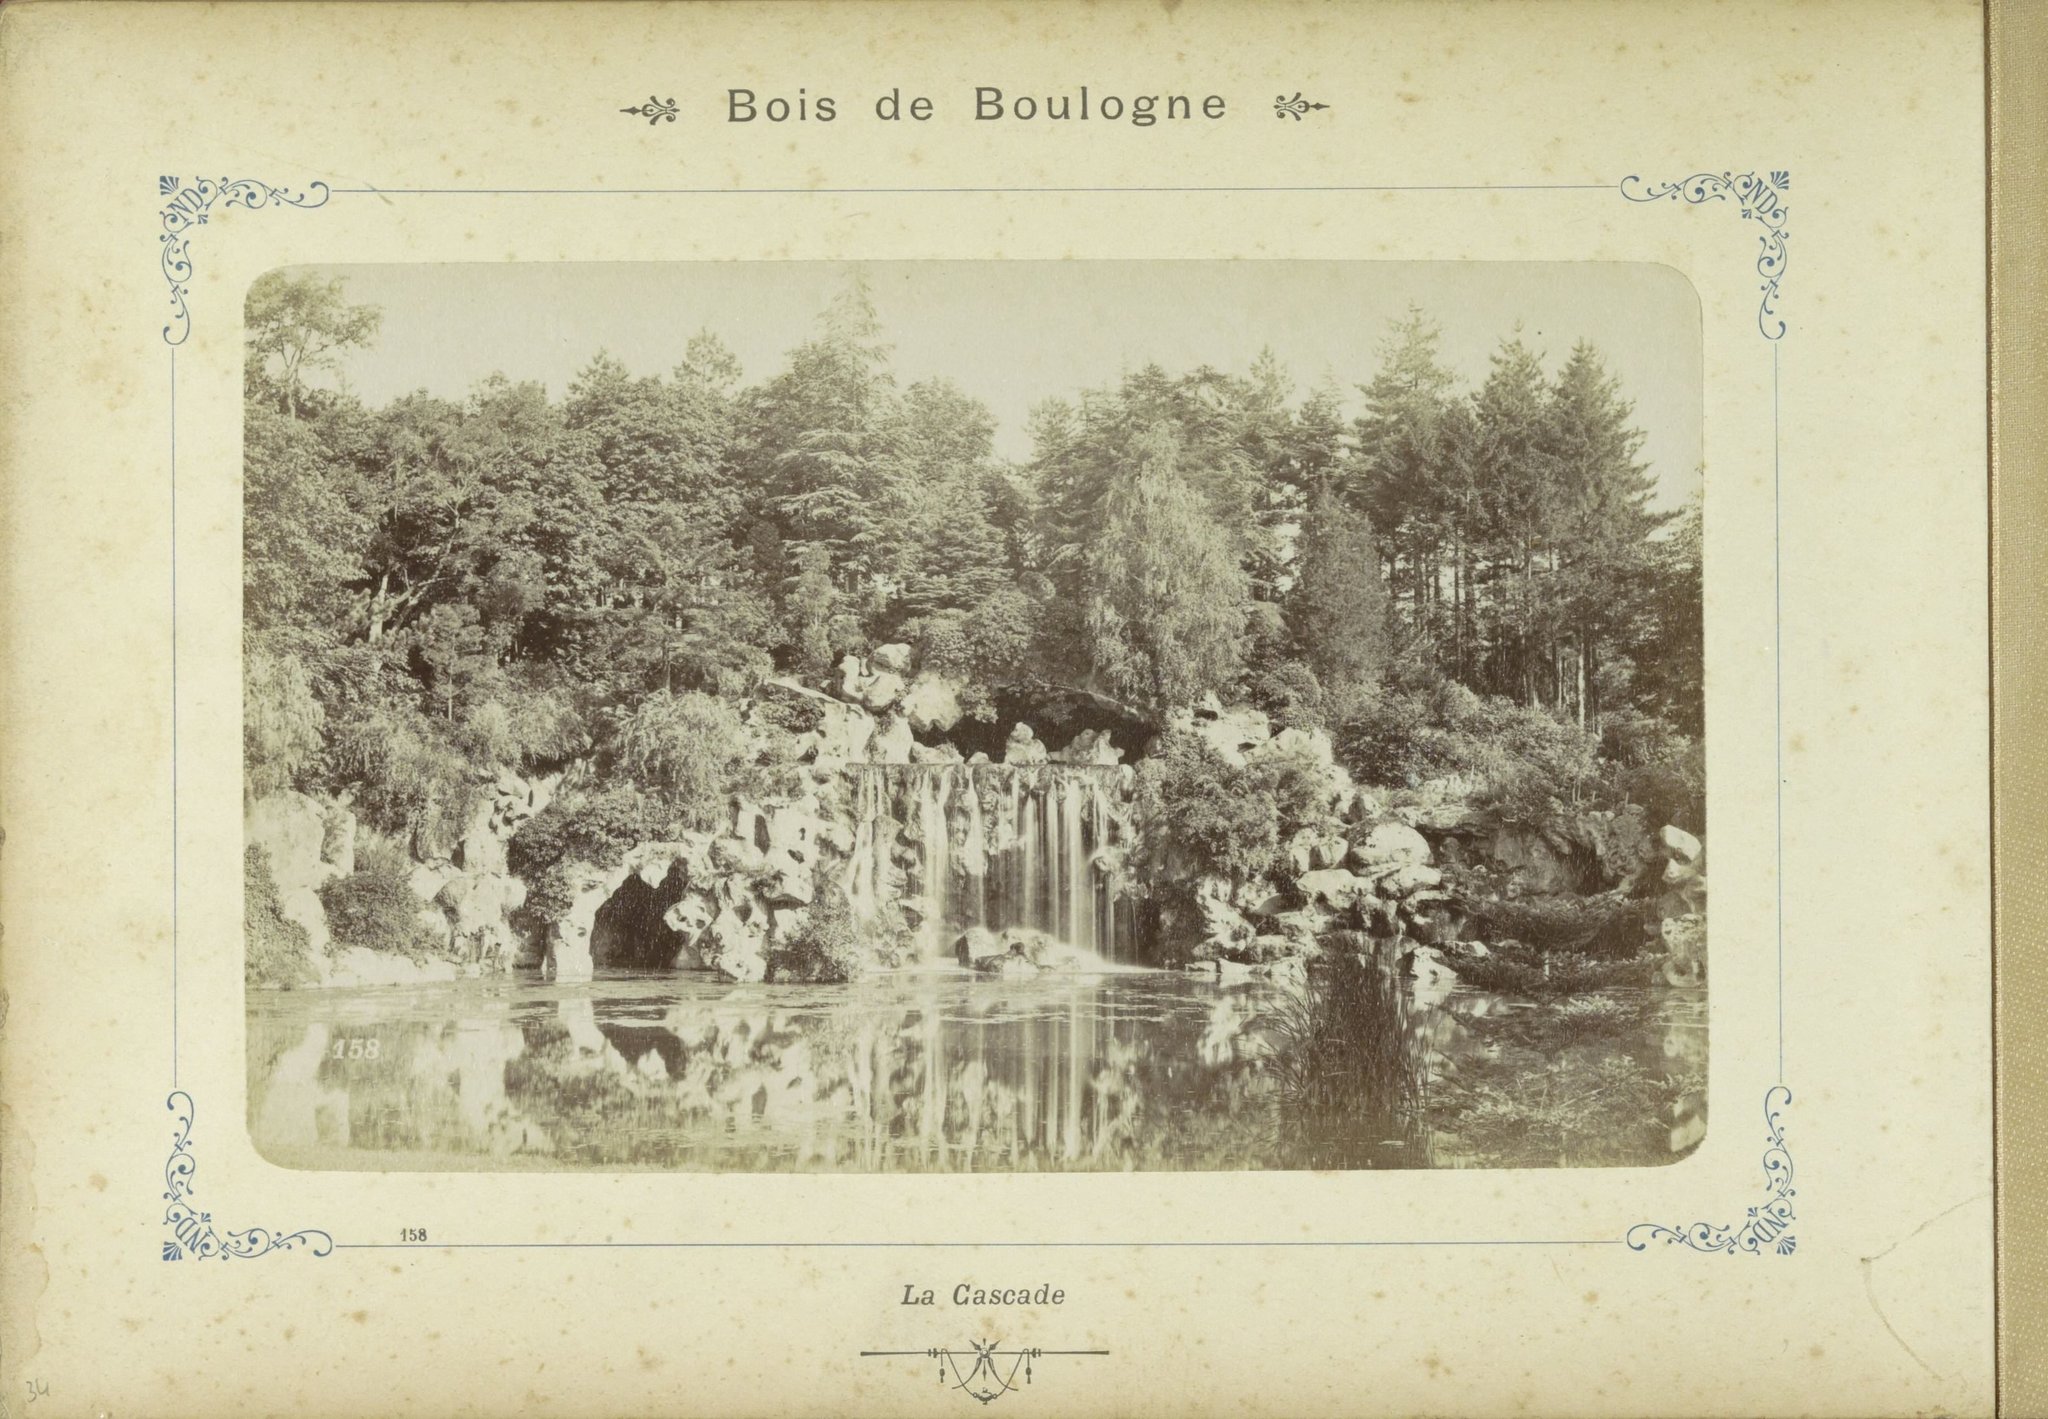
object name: photograph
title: Bois de Boulogne - La Cascade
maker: Anonymous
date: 1900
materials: cardboard, paper, photographic support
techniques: albumen print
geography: paris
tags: waterfall, public gardens, park, garden cascade, paris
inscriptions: number: ‘158’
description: Onderdeel van Fotoalbum met bezienswaardigheden in Parijs, Versailles en het Bois de Boulogne.